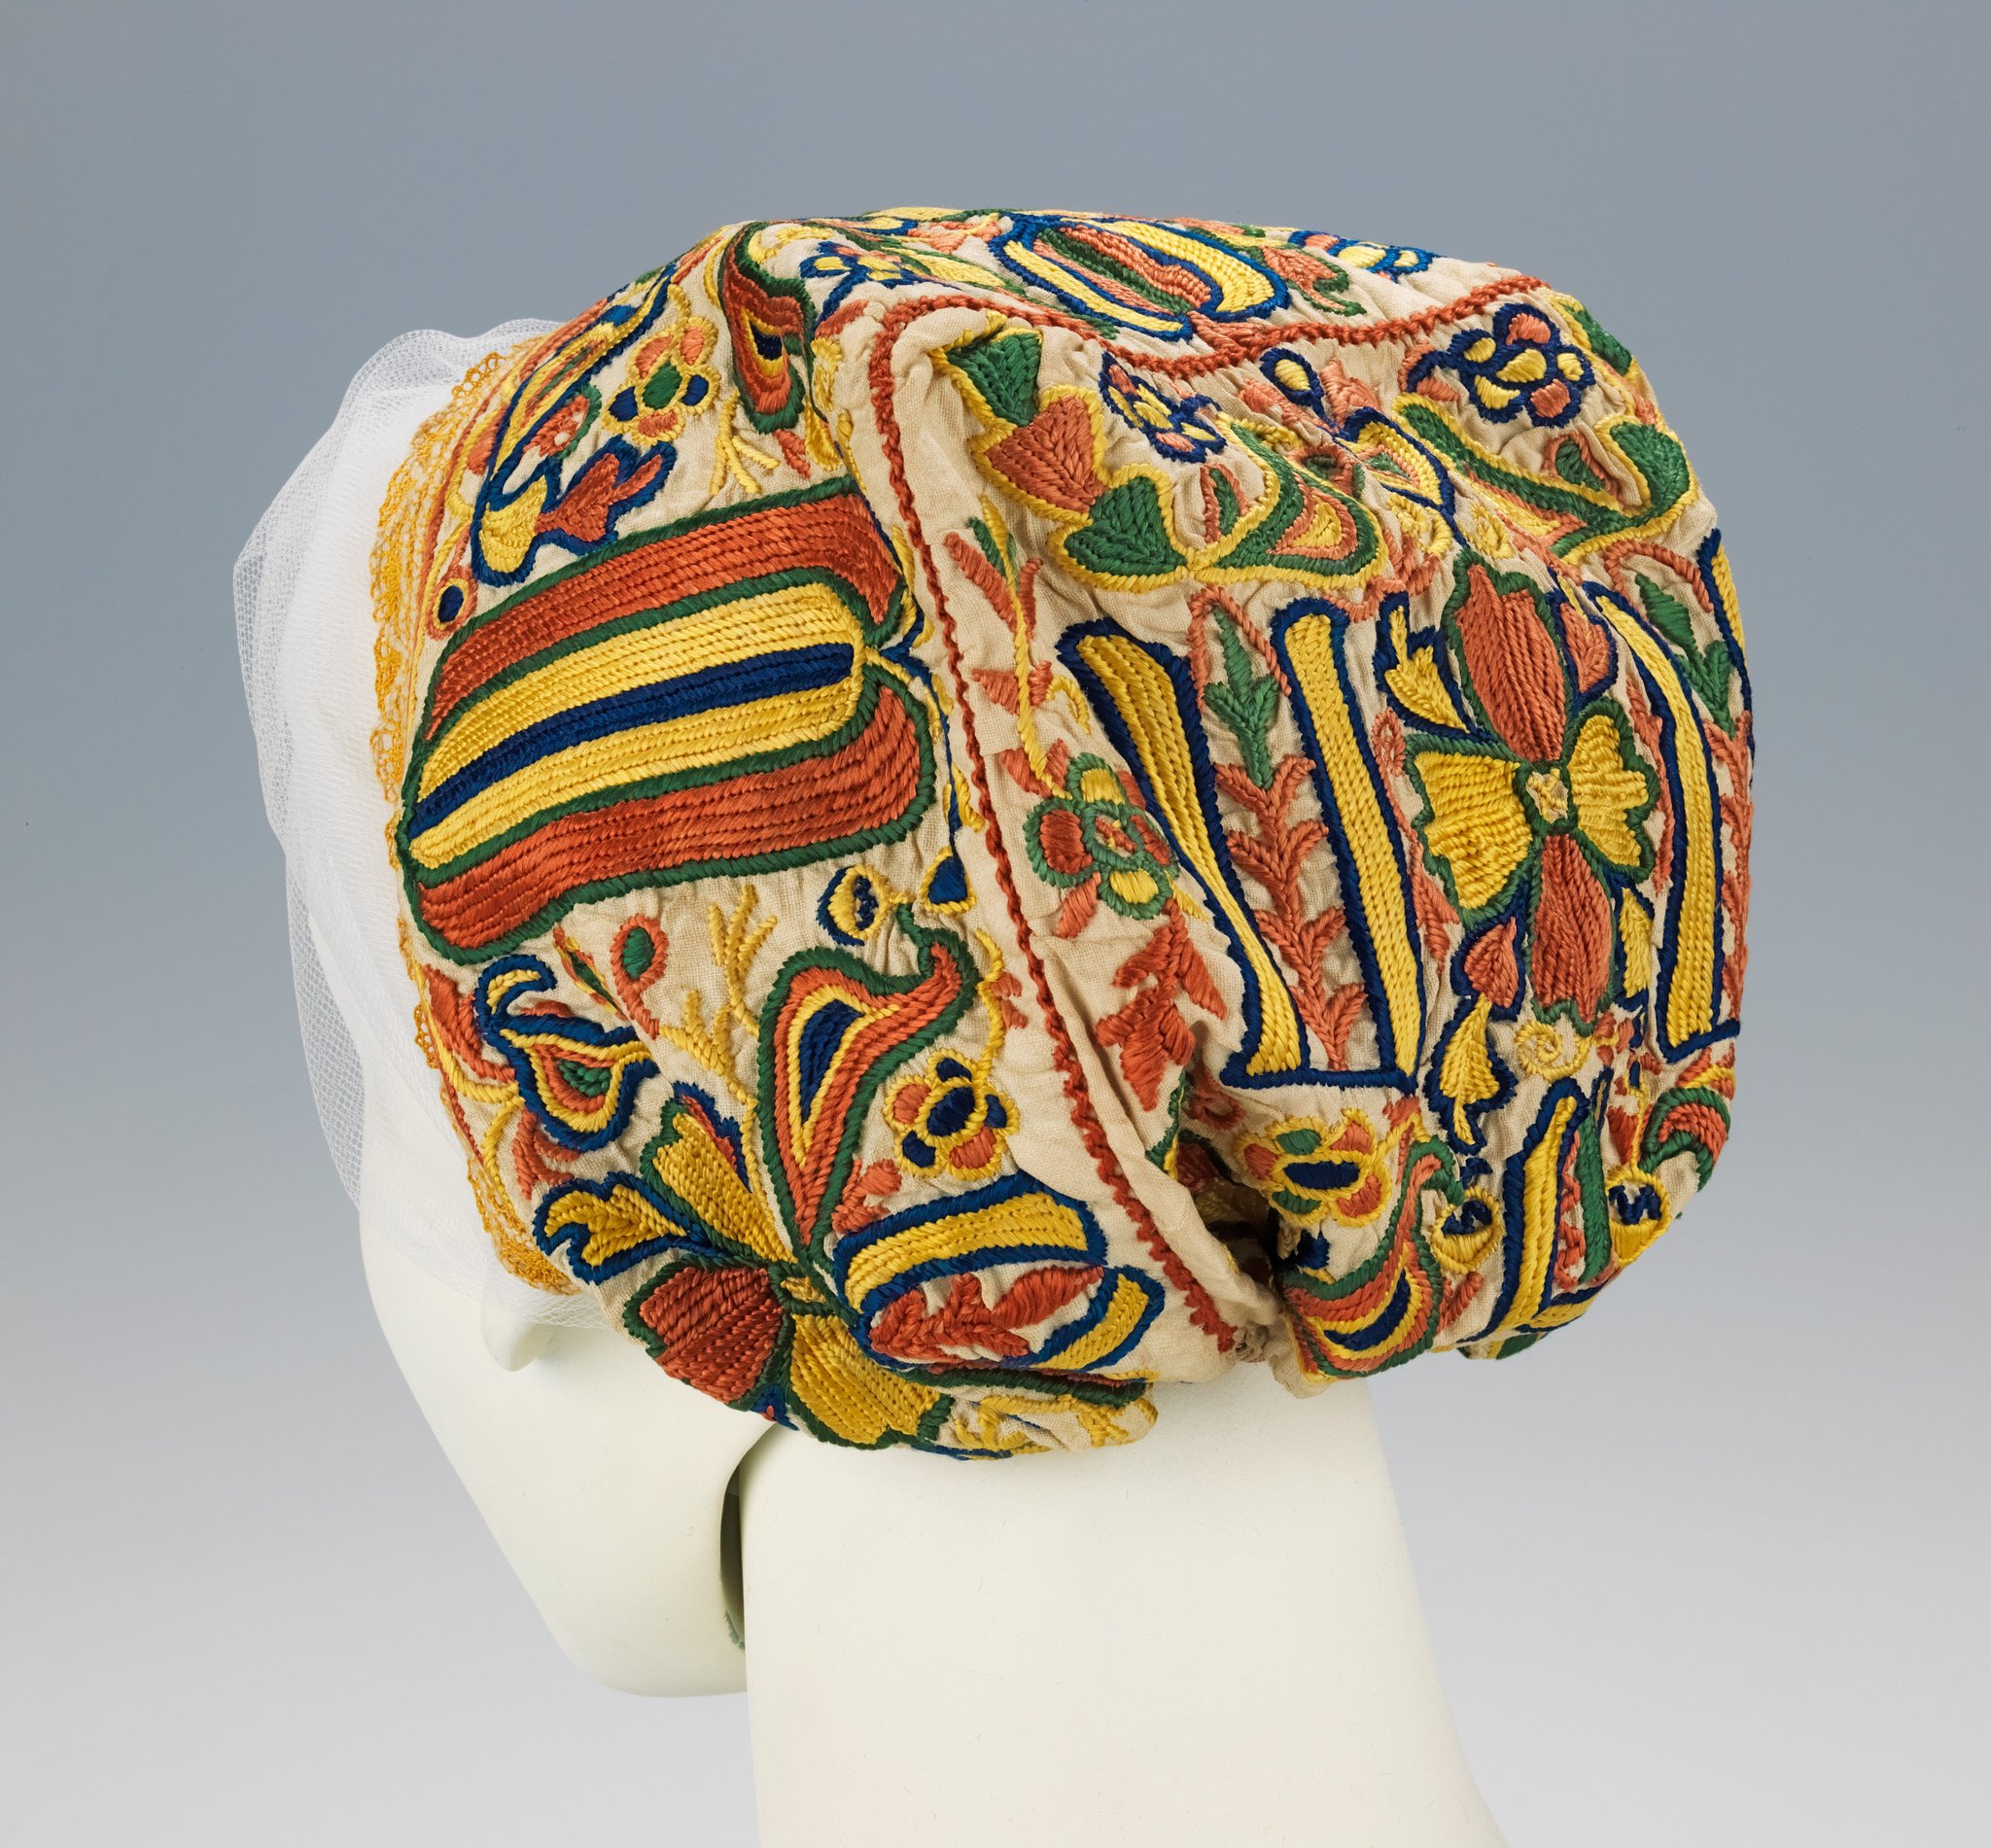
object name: cap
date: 1840-1870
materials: cotton, linen, silk